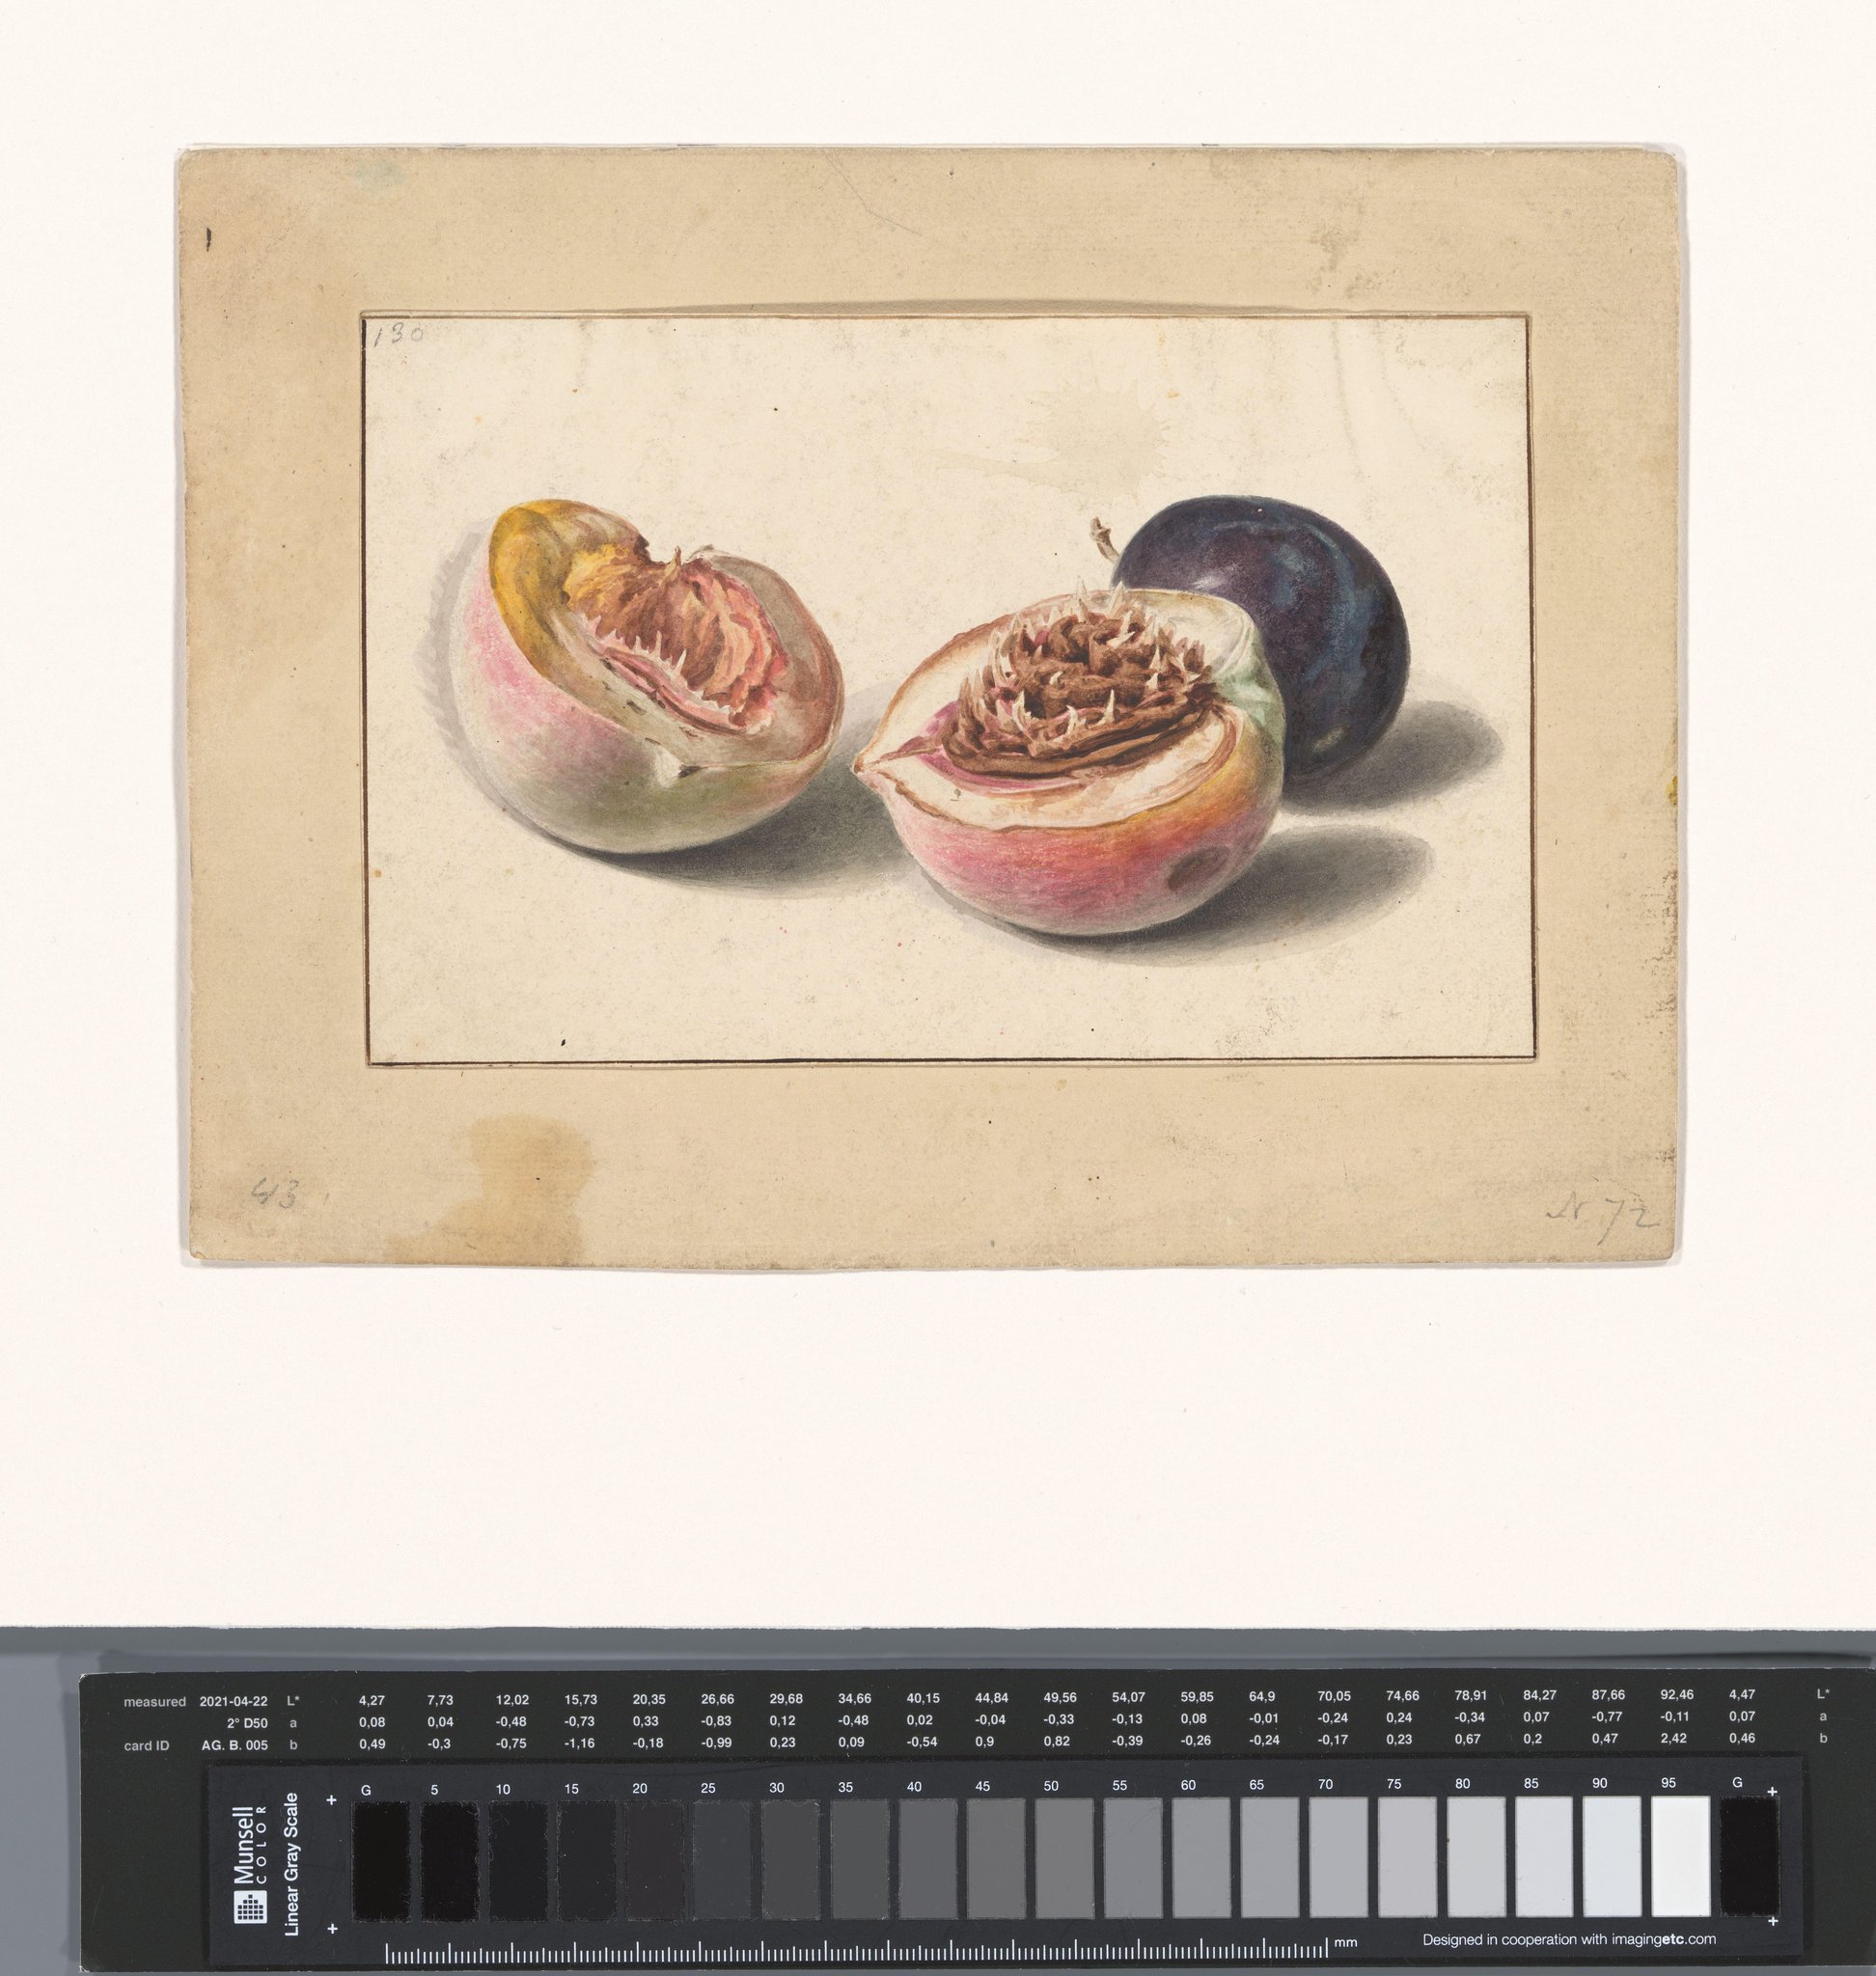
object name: drawing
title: Perzik en pruim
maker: albertus jonas brandt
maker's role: draughtsman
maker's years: 1788-1821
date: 1815-1821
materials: paper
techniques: drawing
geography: amsterdam